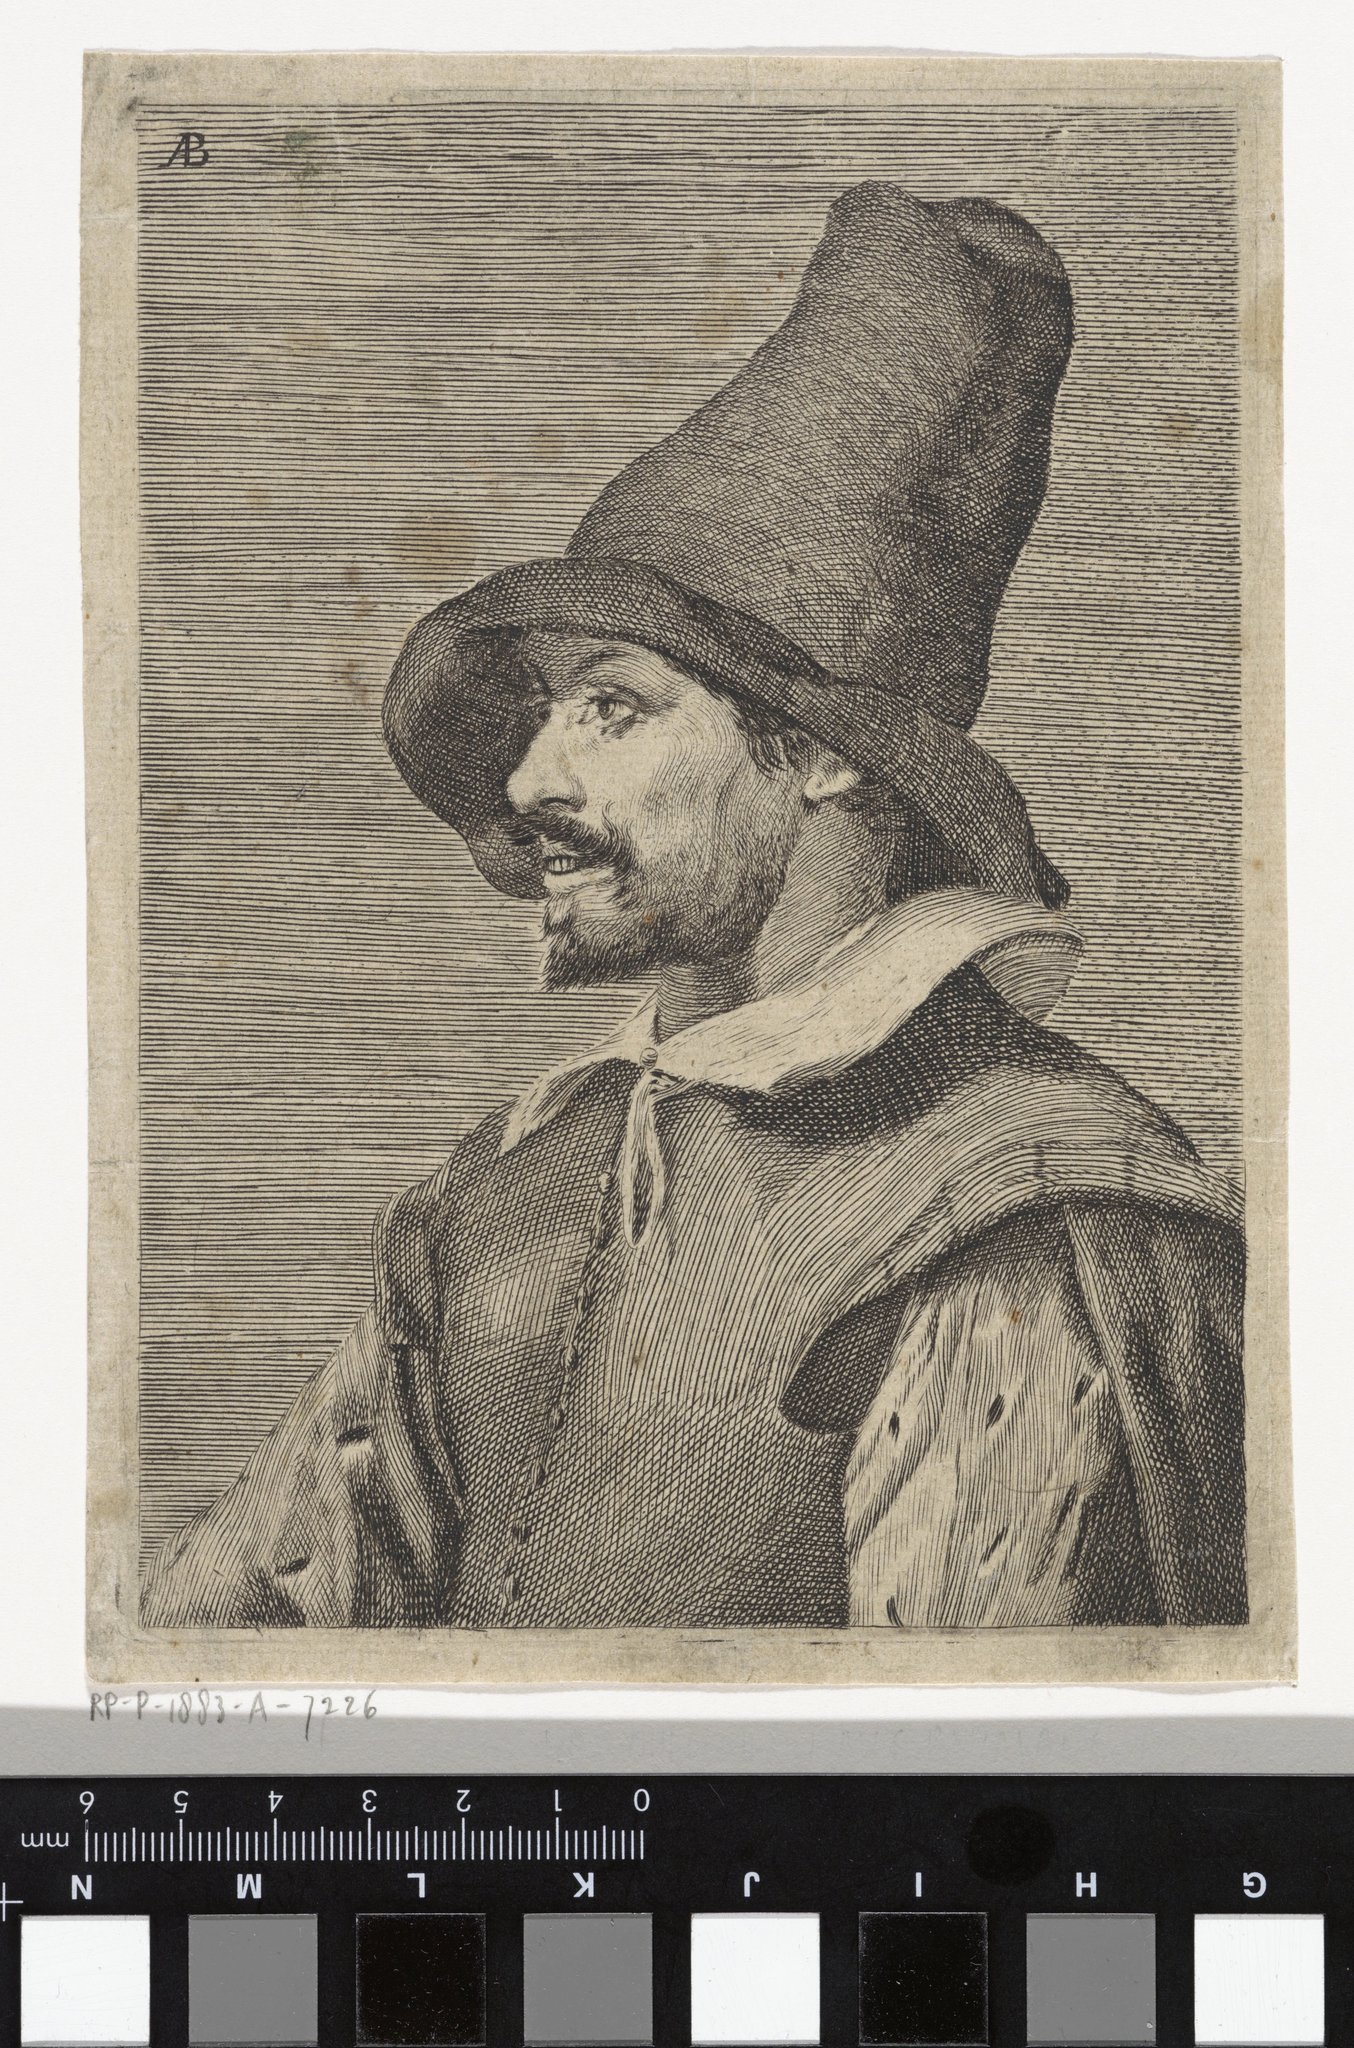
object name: print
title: Portret van Jan Jansz, alias Jan de Dood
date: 1655-1690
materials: paper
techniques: engraving, etching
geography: amsterdam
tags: historical persons, head-gear: hat (+ men's clothes), clothing for the upper part of the body (doublet) (+ men's clothes)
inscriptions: collector's mark: Lugt 2228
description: Buste naar links van Jan Jansz, alias Jan de Dood, met een hoge hoed.